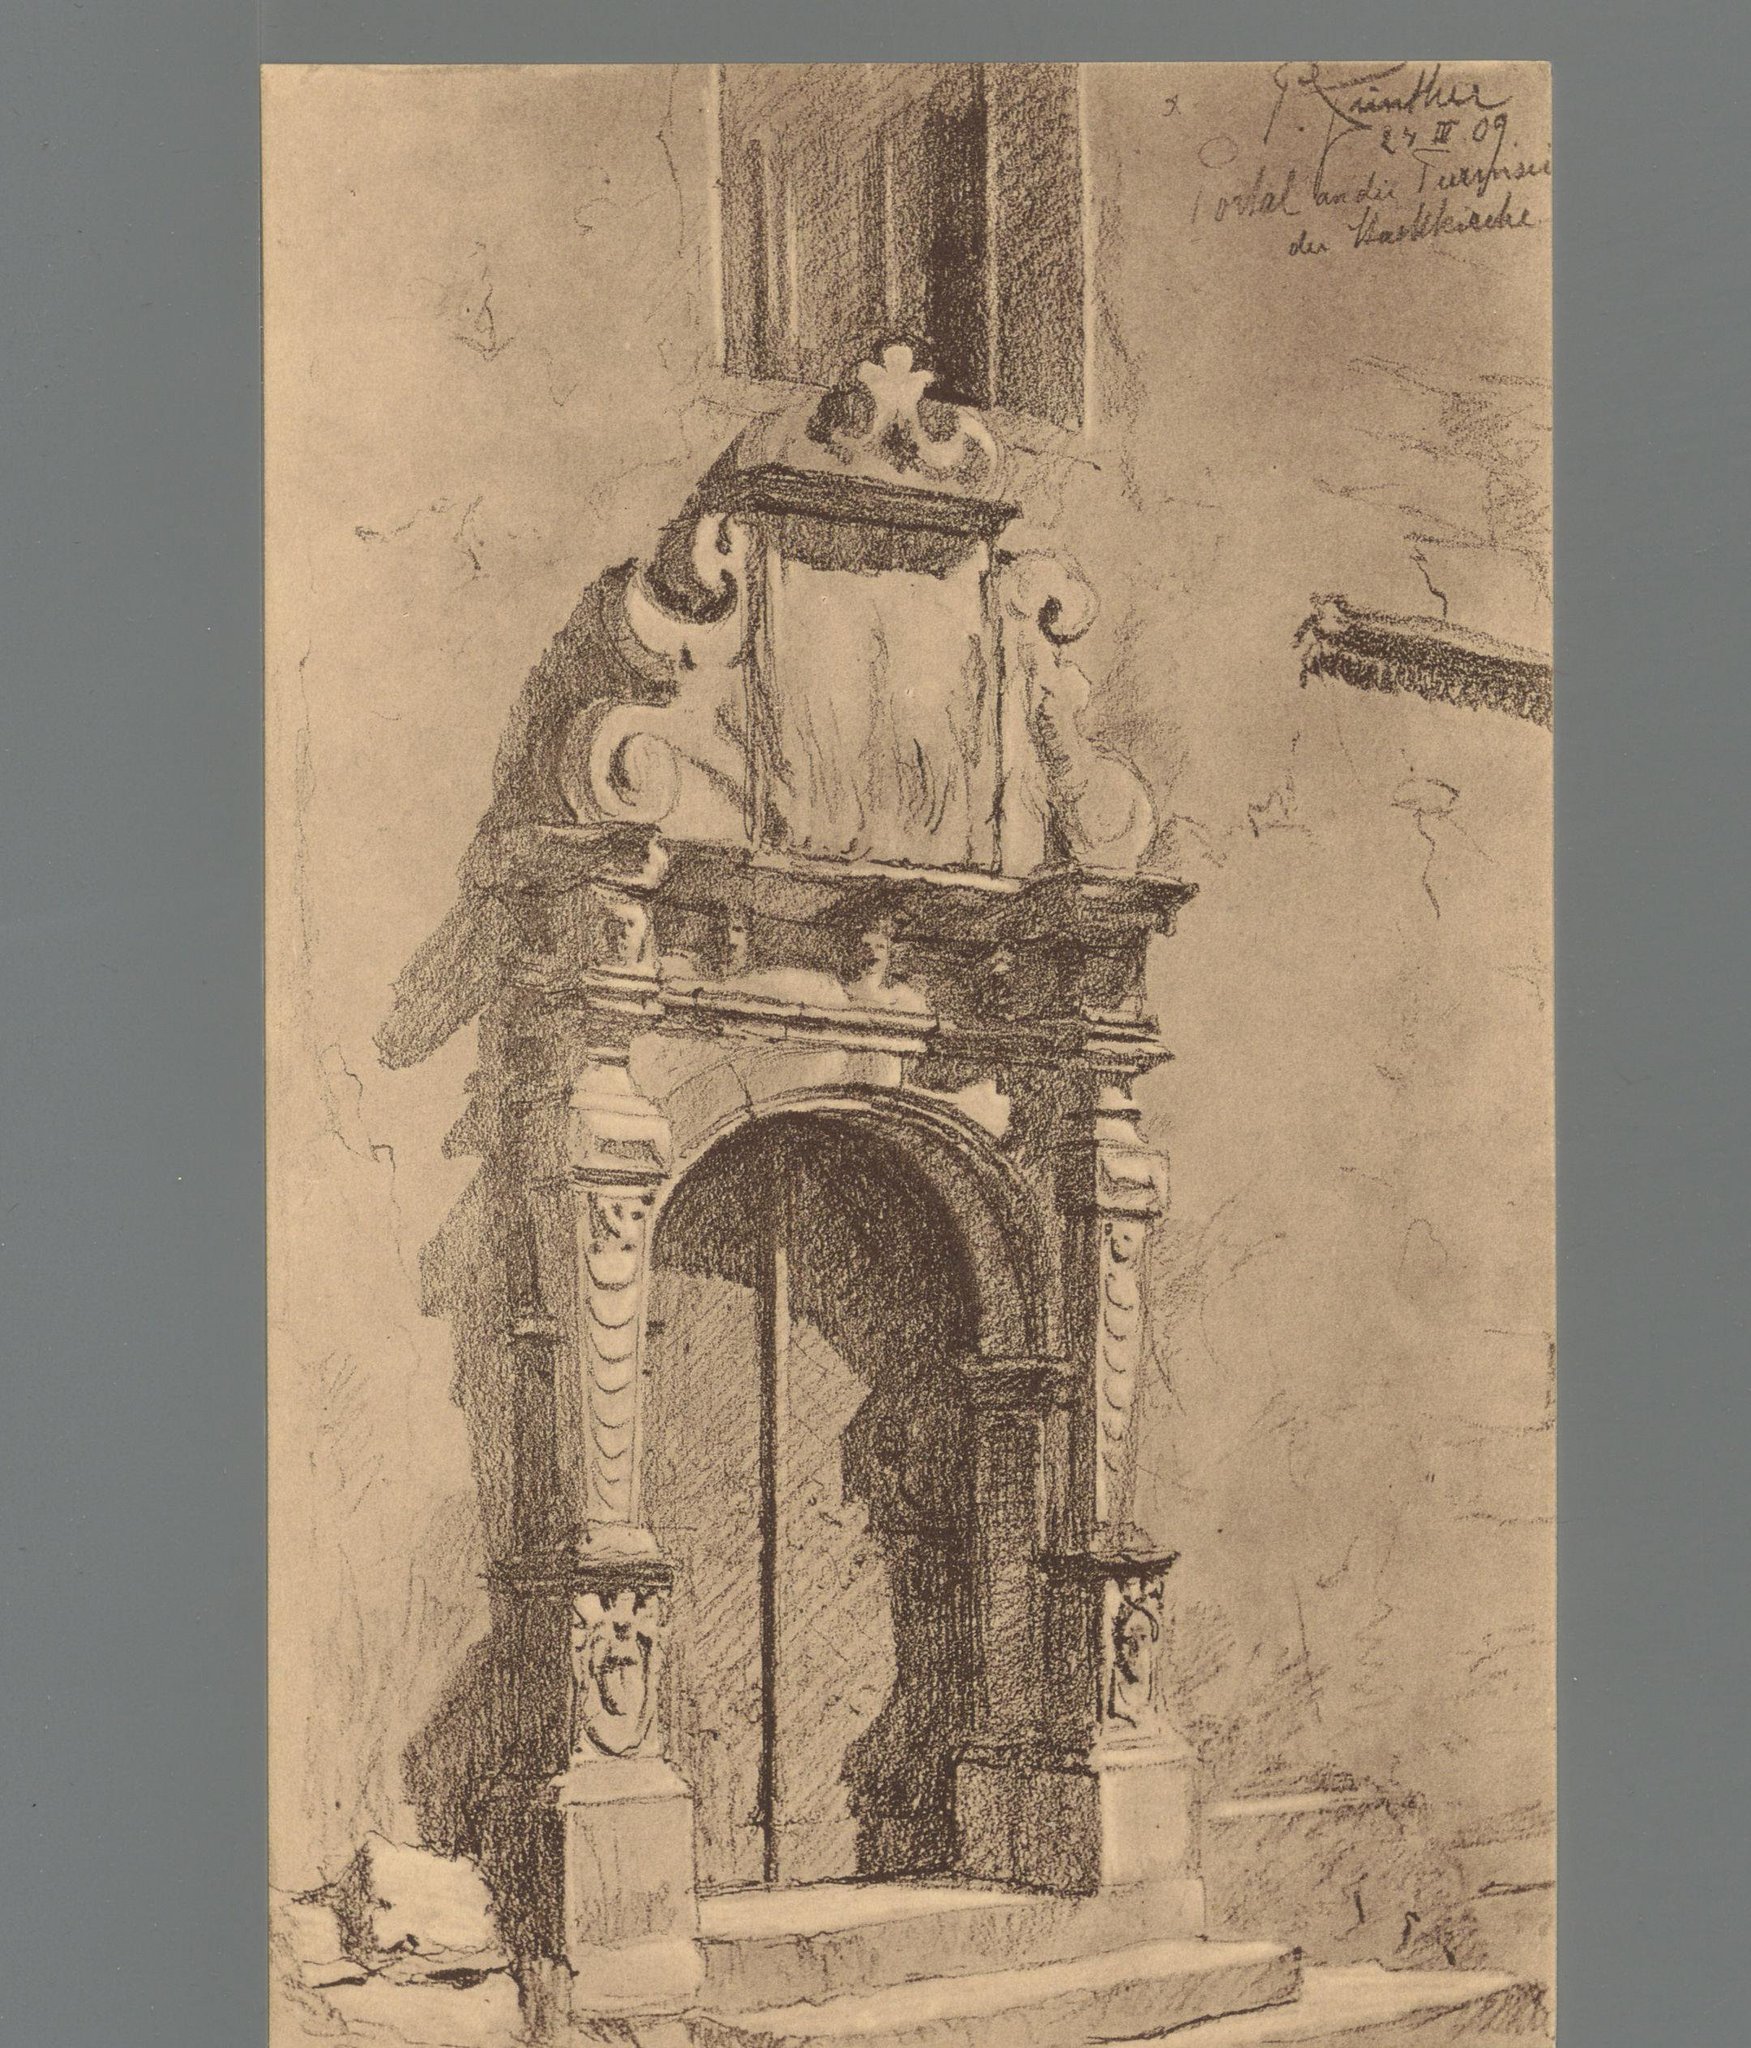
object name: photomechanical print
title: Rudolstadt. Seitenportal der Stadtkirche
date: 1915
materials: cardboard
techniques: photograph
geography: rudolstadt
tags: church (exterior), gate, entrance